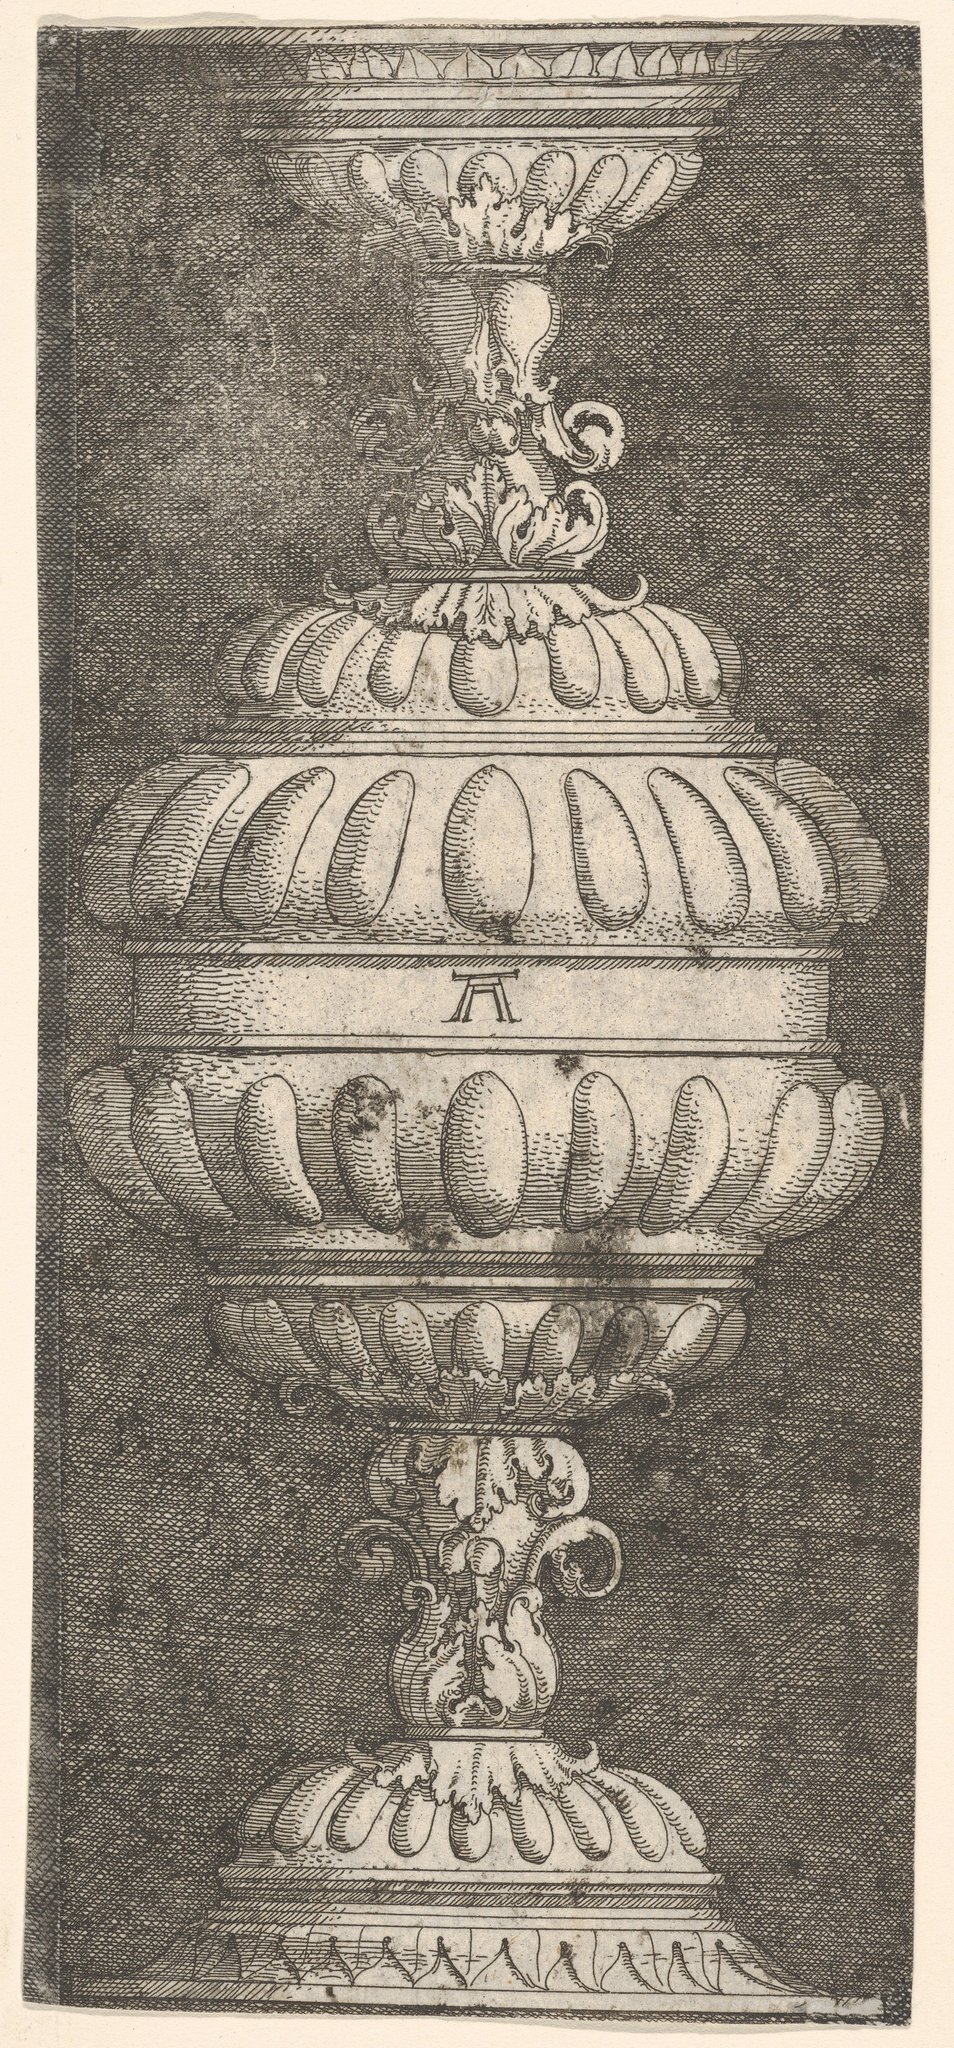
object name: print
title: Double Goblet with Acanthus-Leaves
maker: albrecht altdorfer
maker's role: artist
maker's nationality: german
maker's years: 1480-1538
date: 1500-1538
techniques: etching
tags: goblets